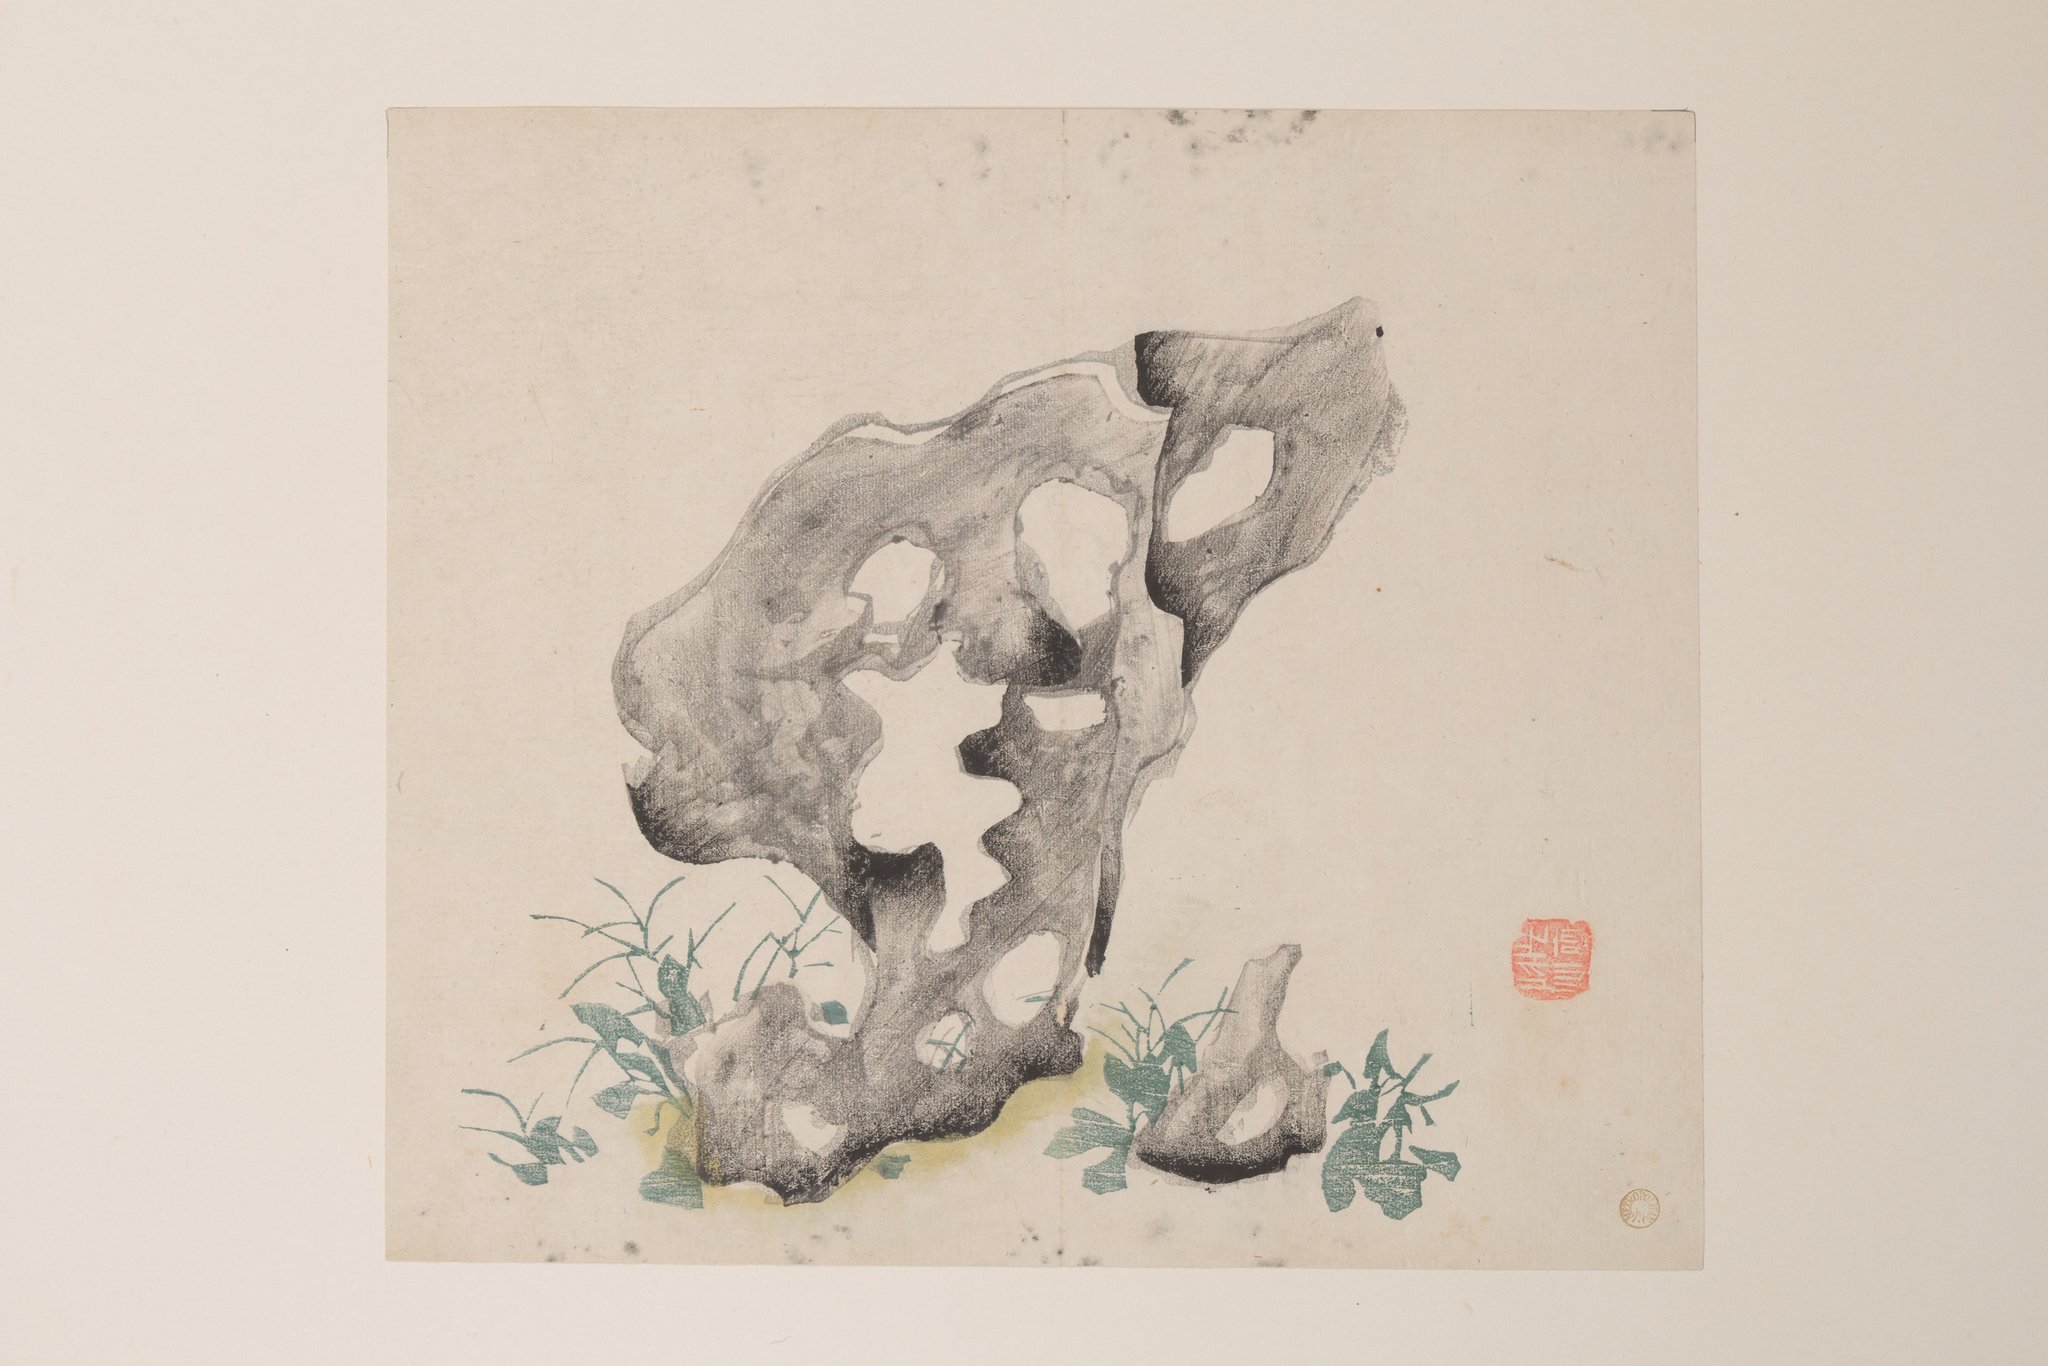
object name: print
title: Page from the Ten Bamboo Studio Manual of Painting and Calligraphy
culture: chinese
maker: hu zhengyan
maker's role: artist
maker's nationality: chinese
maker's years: 1584-1634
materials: ink, paper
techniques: printing